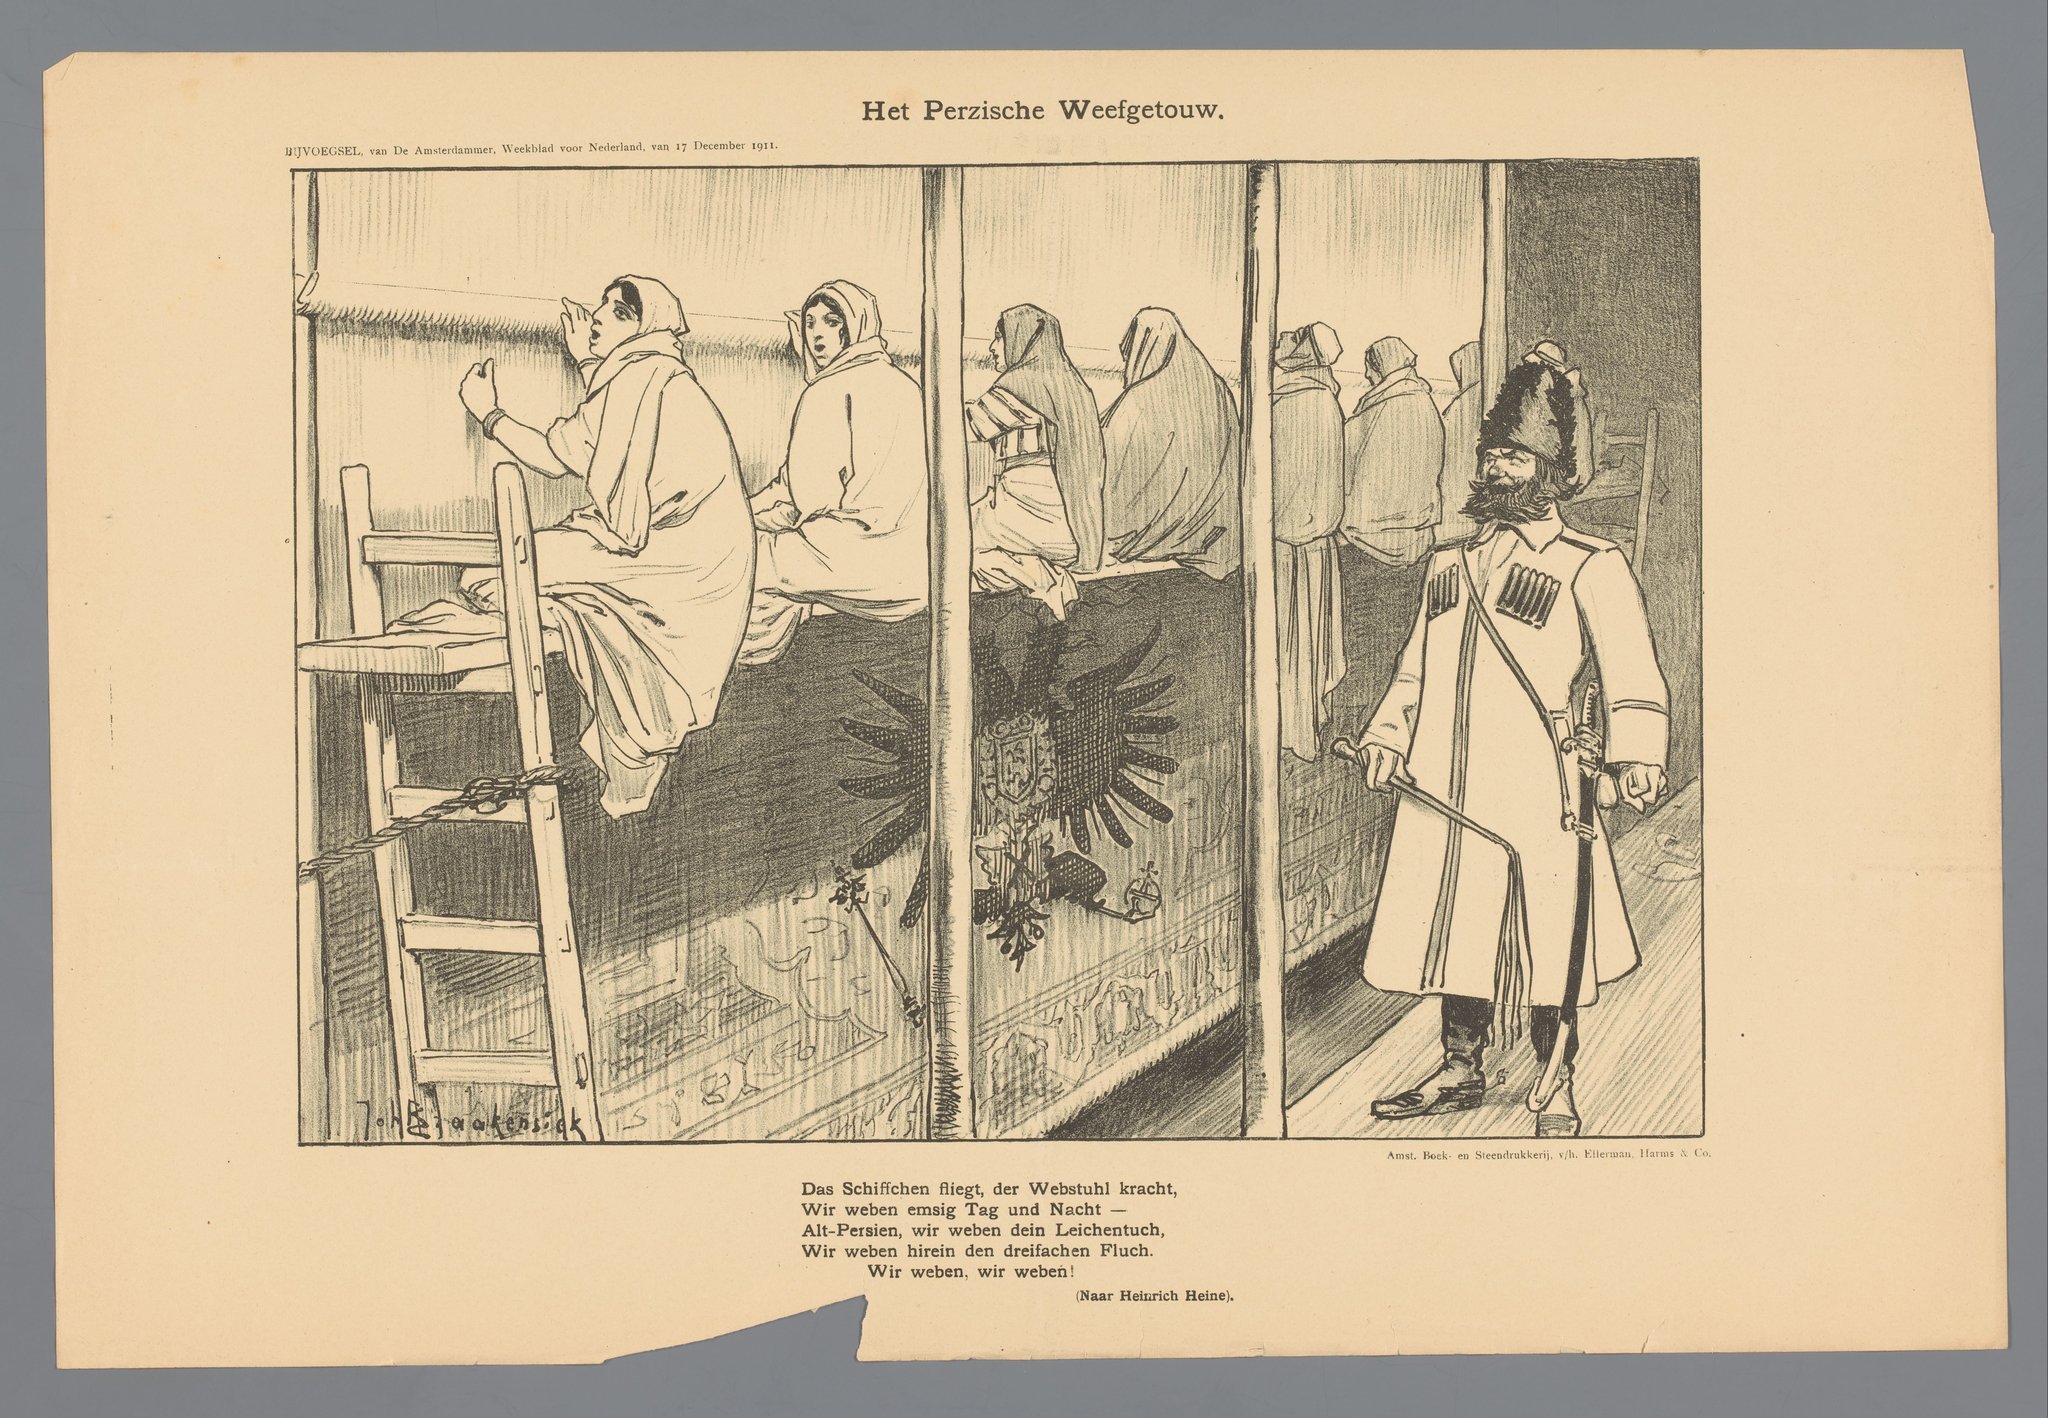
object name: cartoon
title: Het Perzische Weefgetouw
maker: johan braakensiek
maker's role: draughtsman, print maker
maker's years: 1858-1940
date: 1911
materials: paper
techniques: lithograph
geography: amsterdam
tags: weaving-loom, political caricatures and satires, russia, persia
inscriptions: date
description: Prent uit het bijvoegsel van: De Amsterdammer. Weekblad voor Nederland, 17 december 1911.